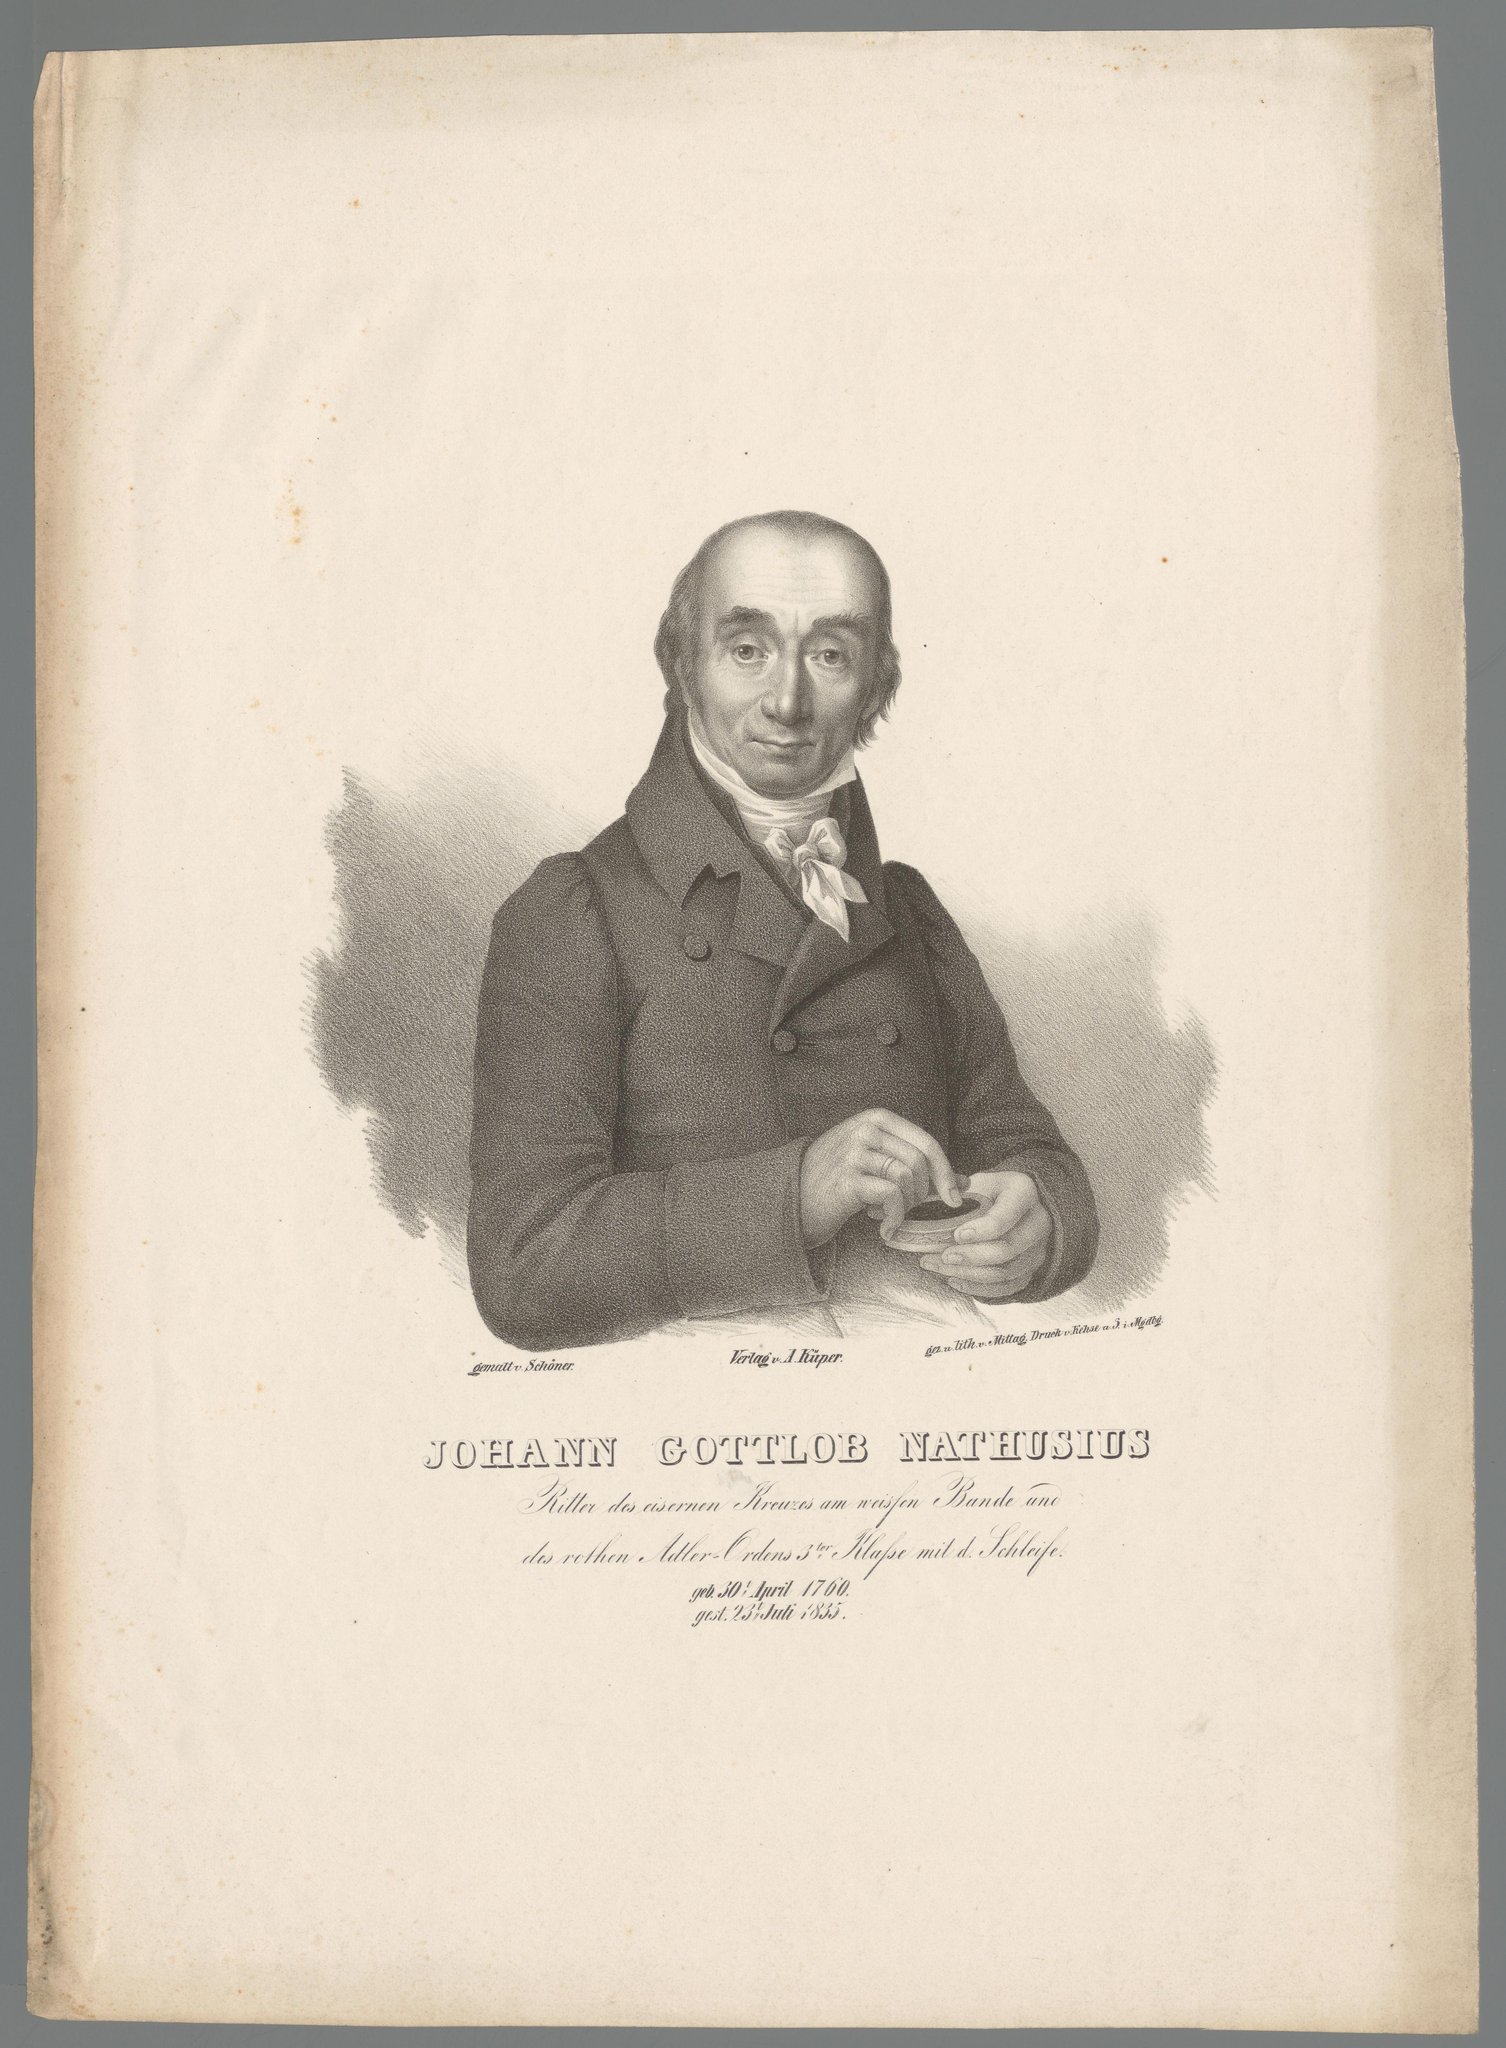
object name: print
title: Portret van Johann Gottlob Nathusius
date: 1835-1850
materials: paper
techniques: lithograph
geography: magdeburg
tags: adult man, historical persons